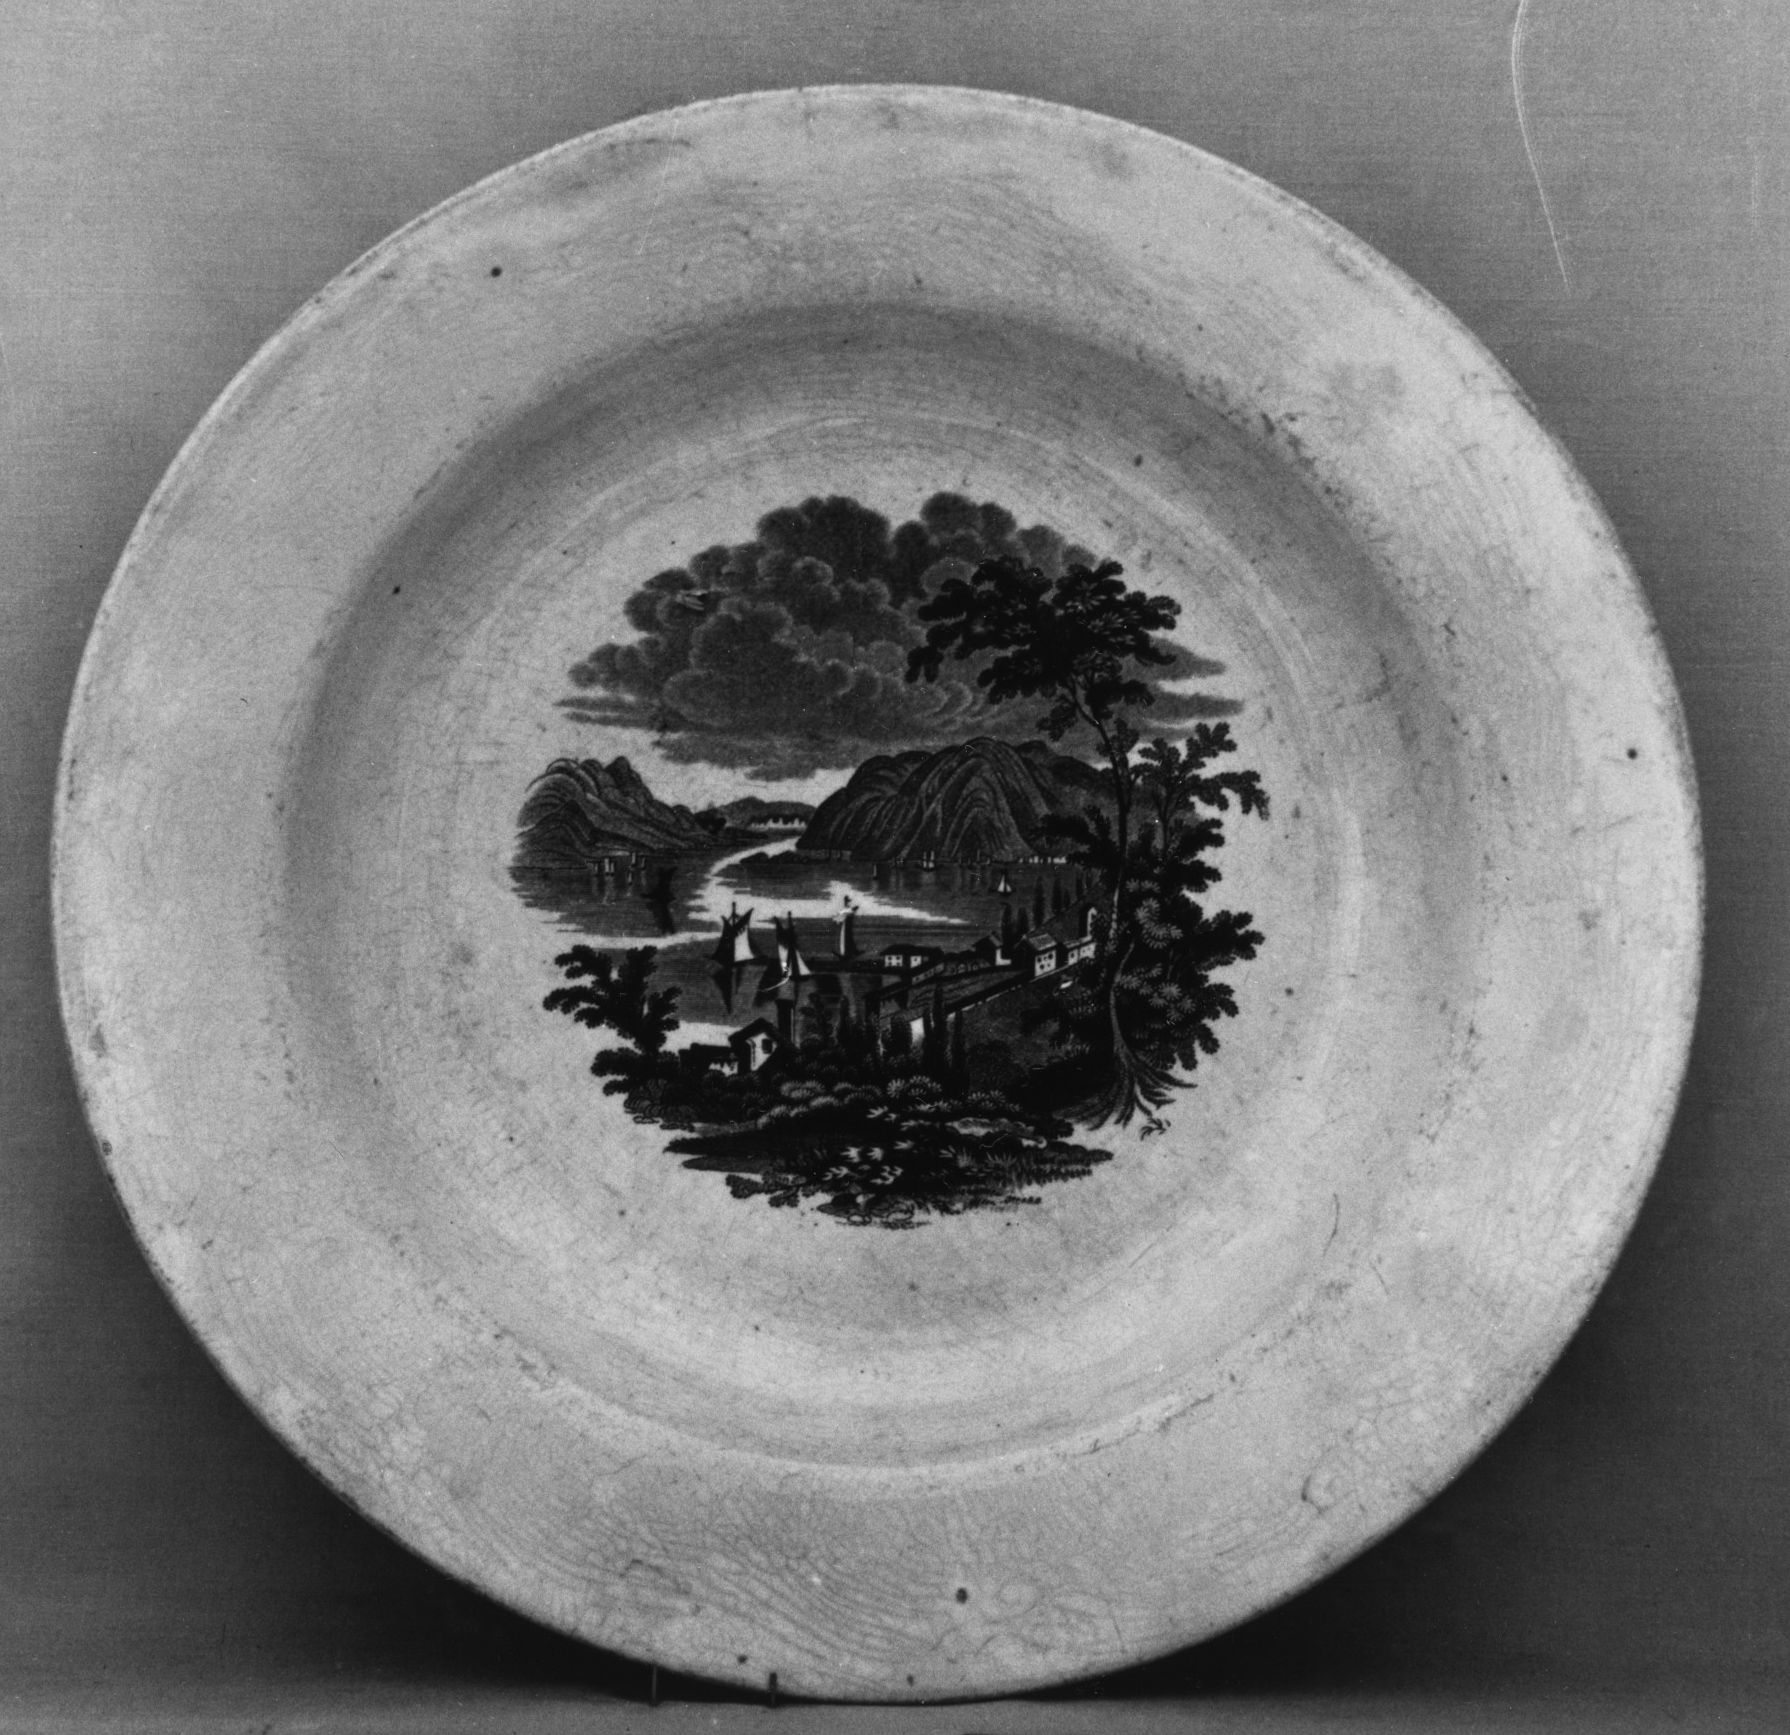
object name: plate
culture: british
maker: william ridgway & co.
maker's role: maker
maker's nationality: british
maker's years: 1834-1854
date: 1840-1854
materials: earthenware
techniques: transfer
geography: england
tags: landscapes